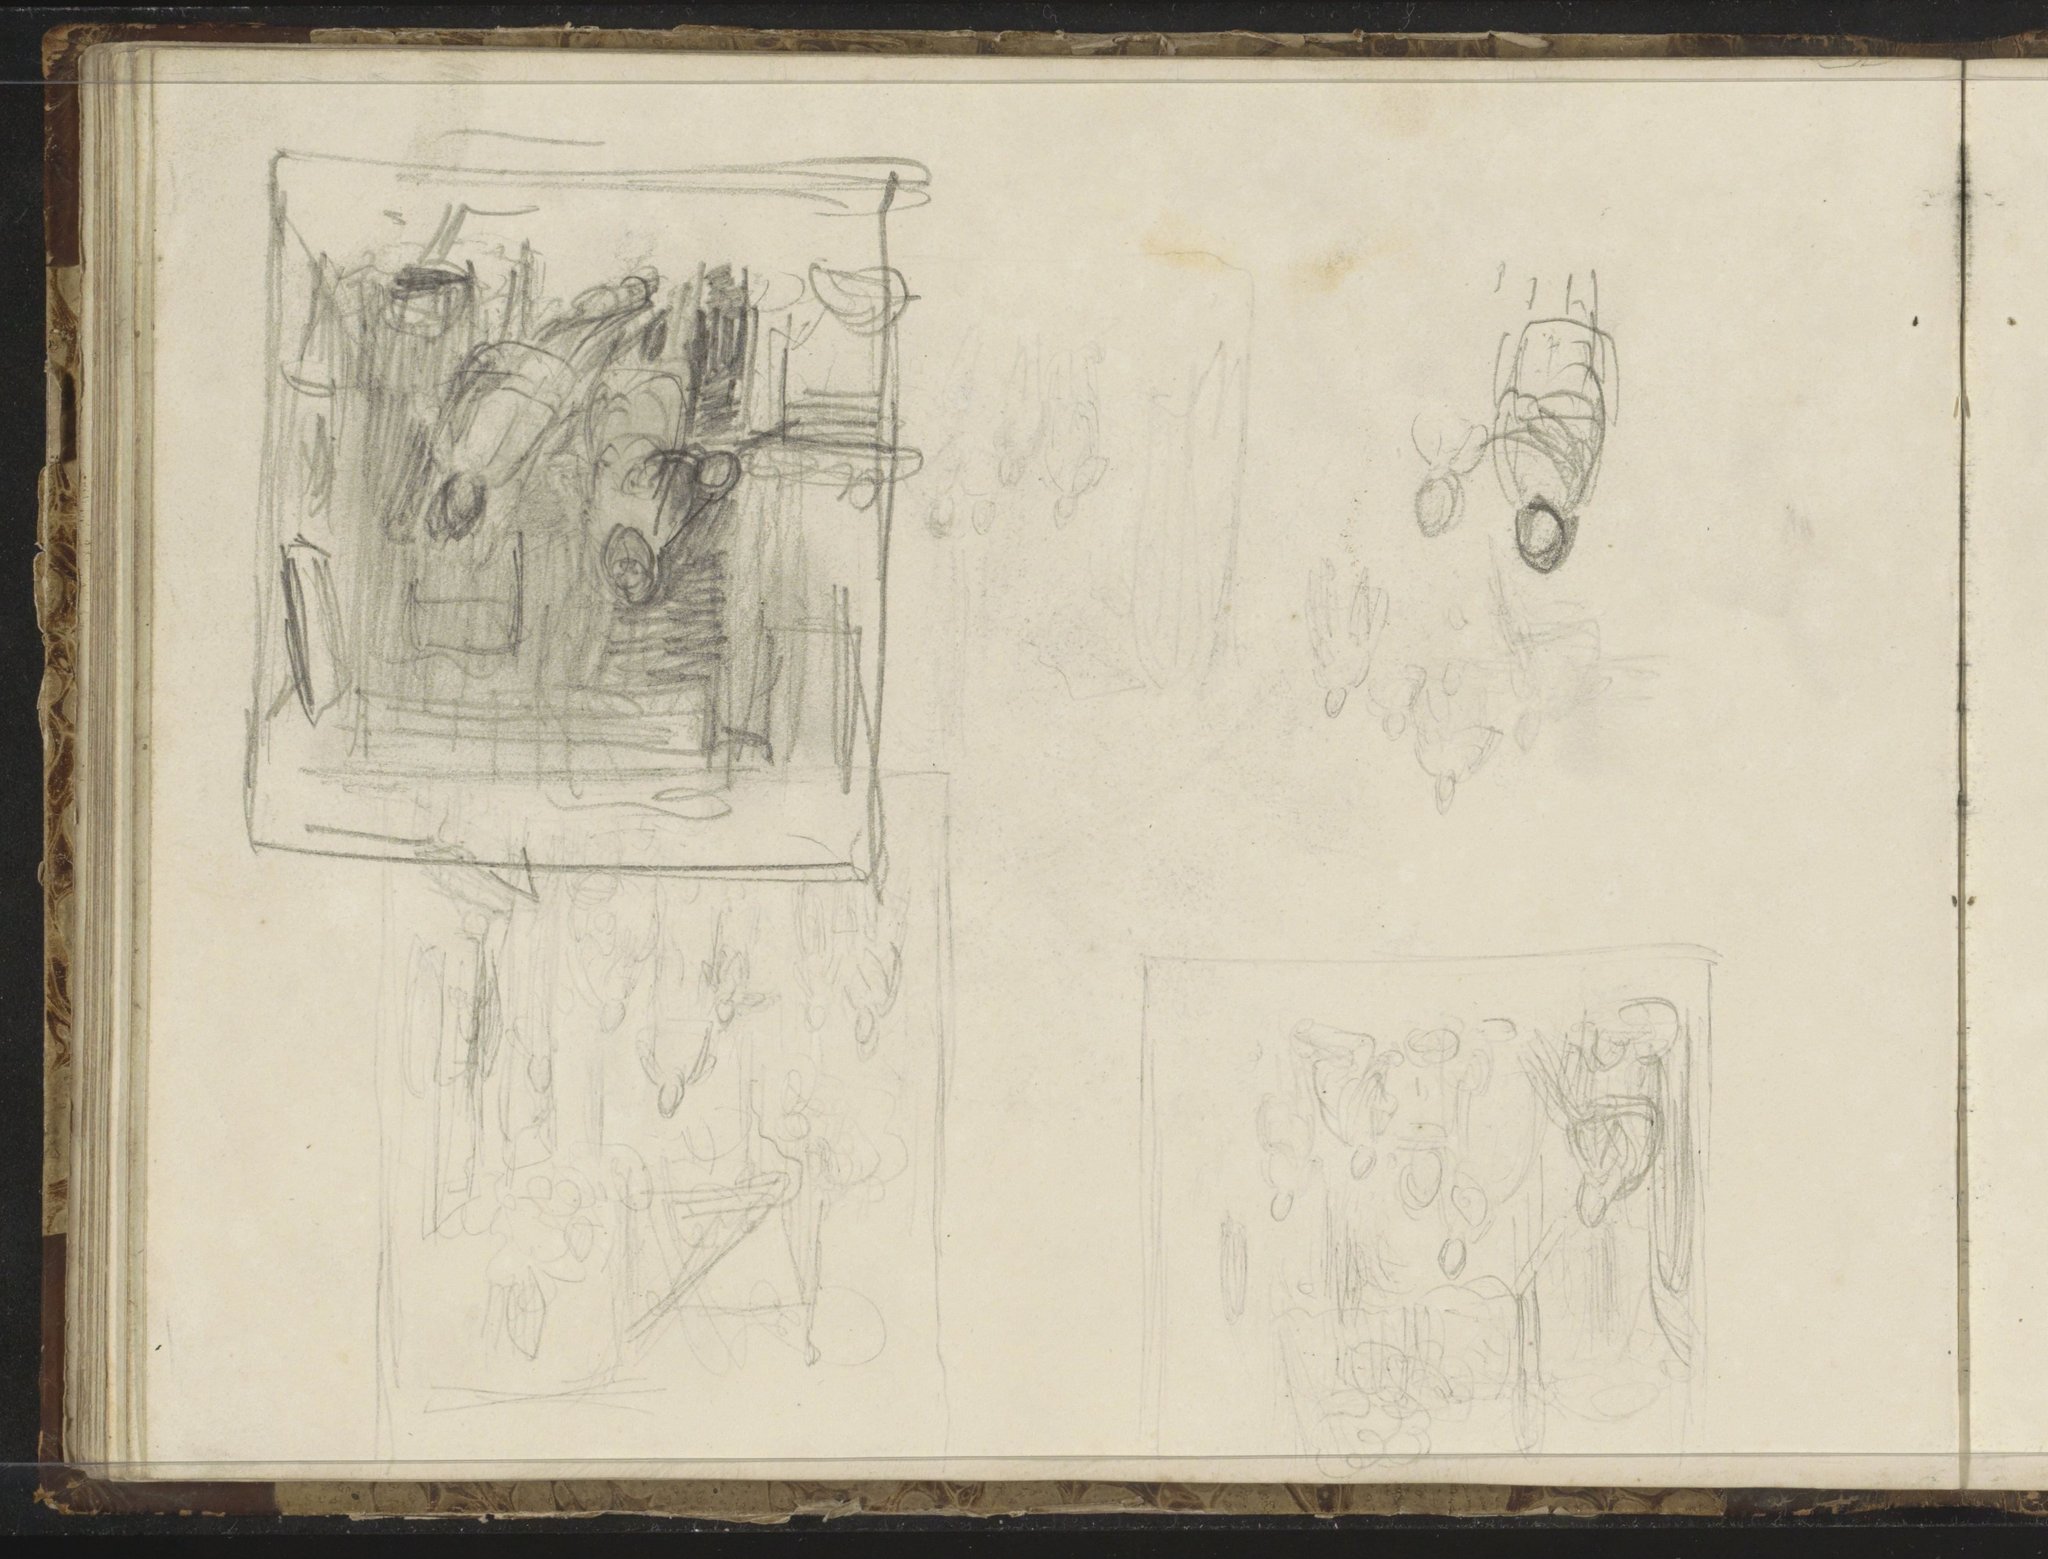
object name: sketchbook leaf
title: Compositiestudies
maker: willem hendrik schmidt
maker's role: draughtsman, painter, print maker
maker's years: 1809-1849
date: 1819-1849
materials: paper, pencil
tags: interior of the house, street (+ city(-scape) with figures, staffage)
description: Tekeningen in kaders. Onder andere studies van twee figuren in een interieur en een straat met figuren. Blad 35 verso uit een schetsboek met 52 bladen.